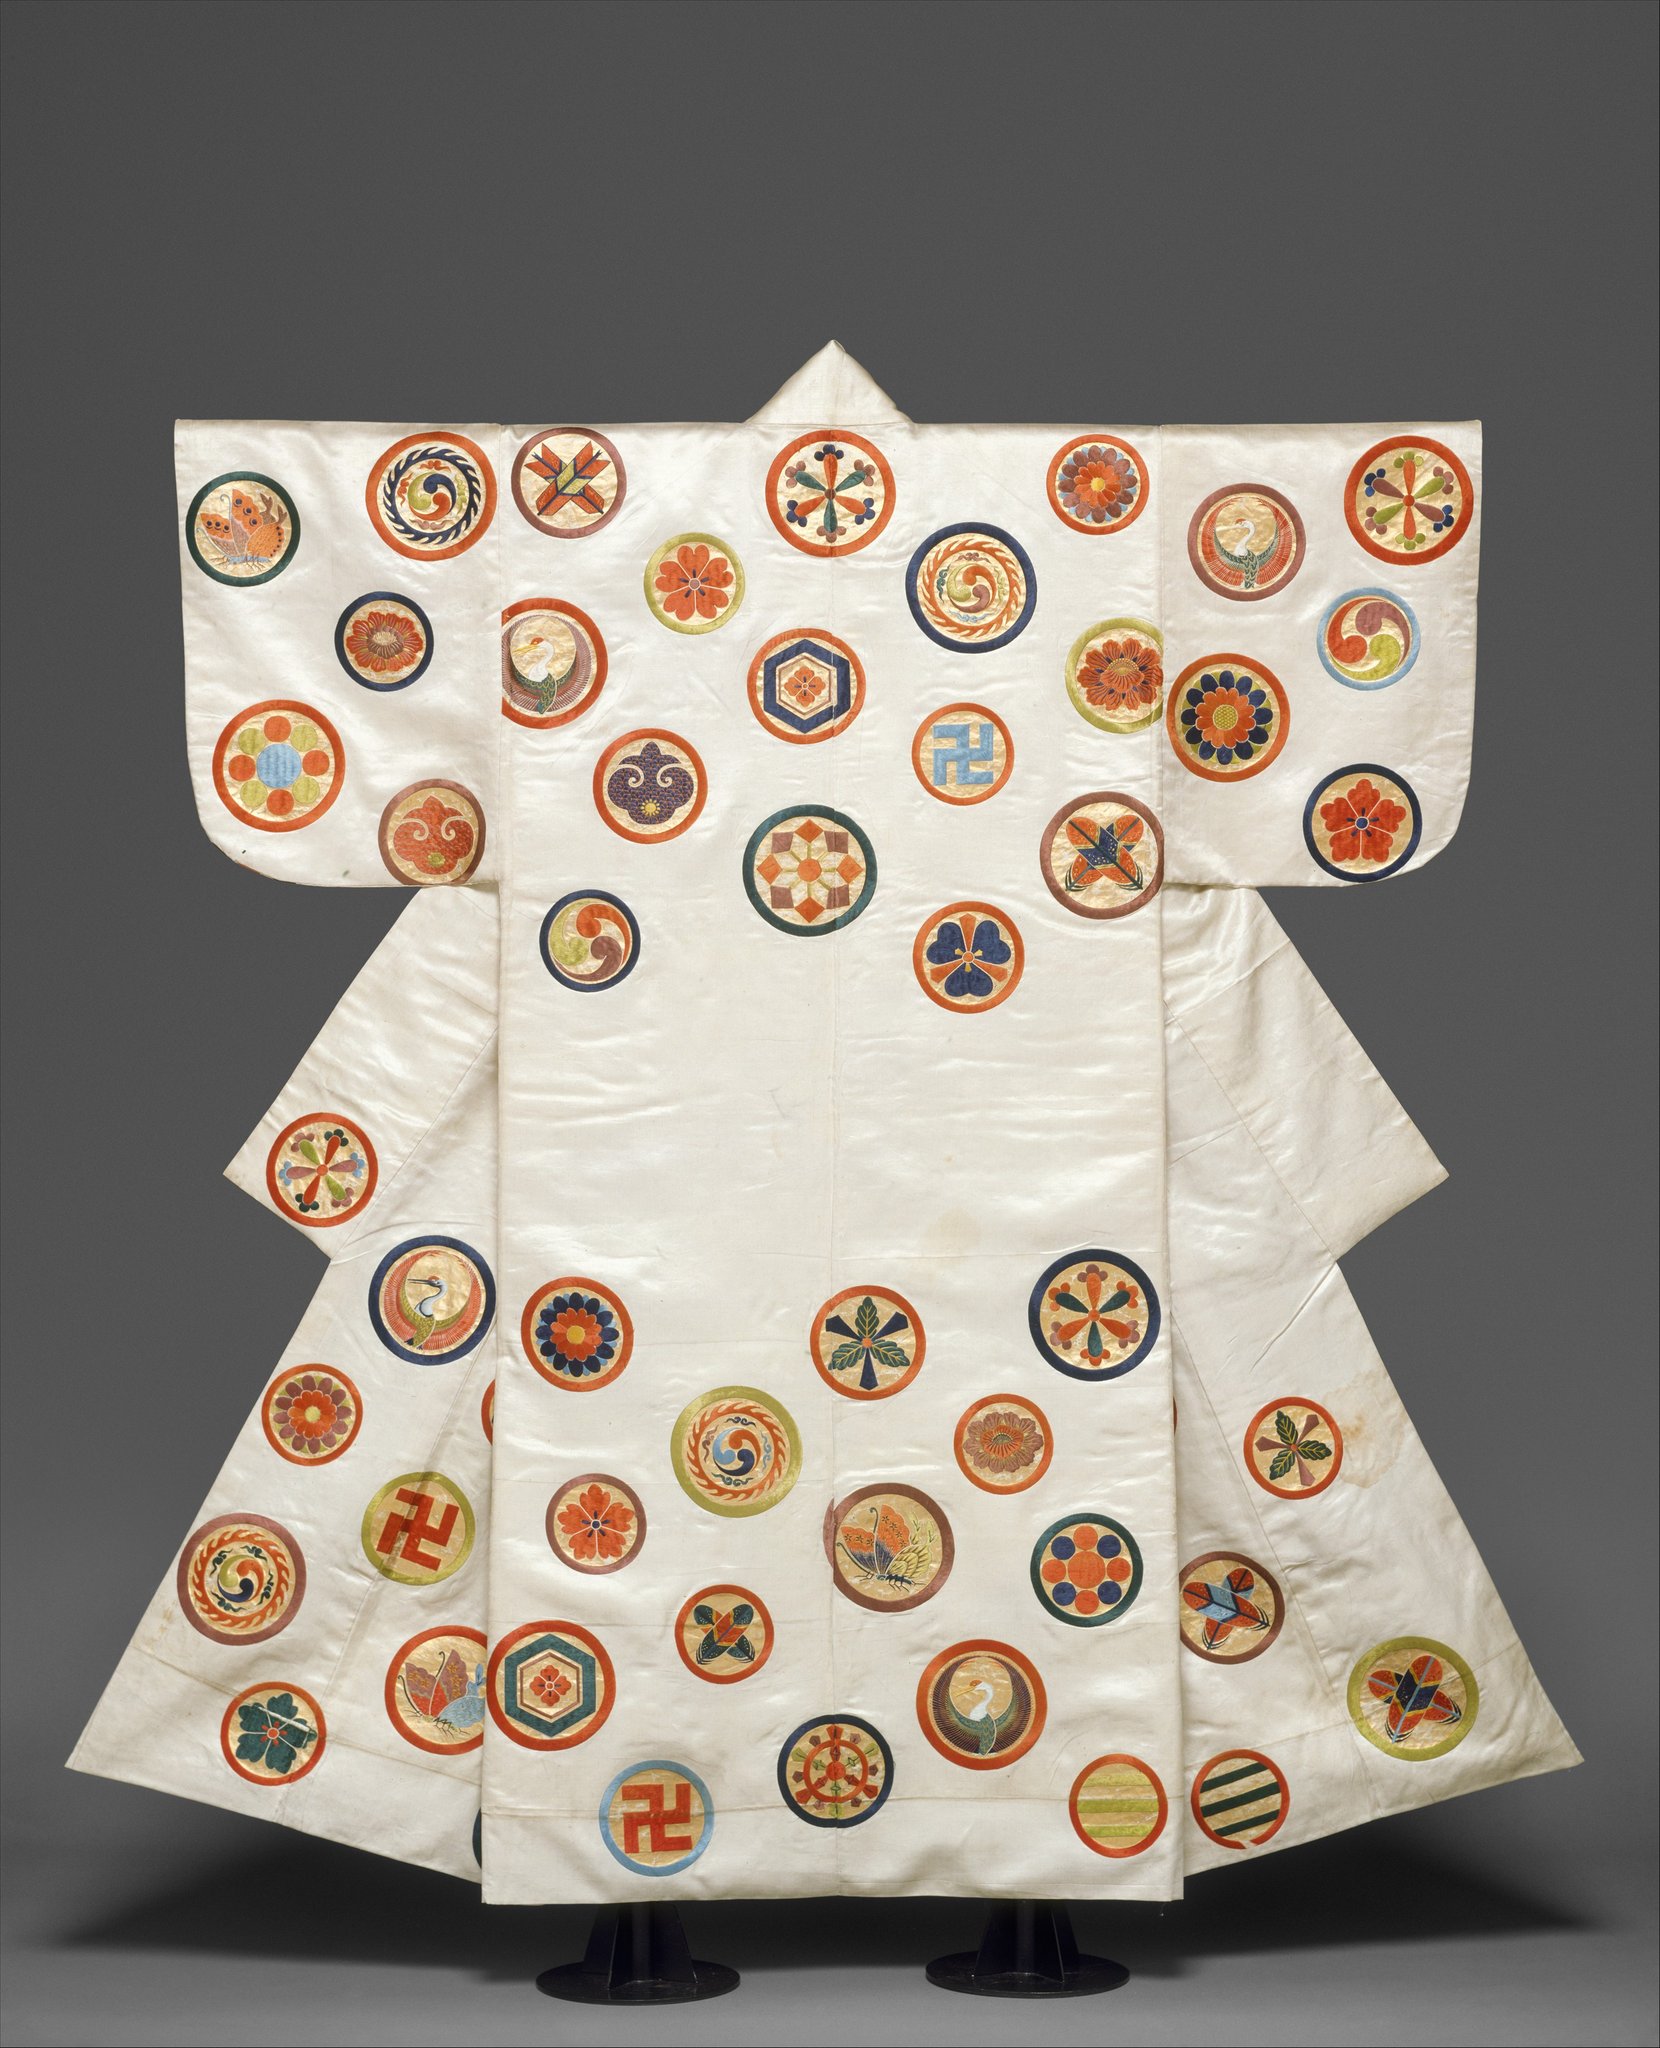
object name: noh costume nuihaku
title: Noh Costume (Nuihaku) with Scattered Crests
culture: japanese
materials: gold leaf, silk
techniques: embroidery